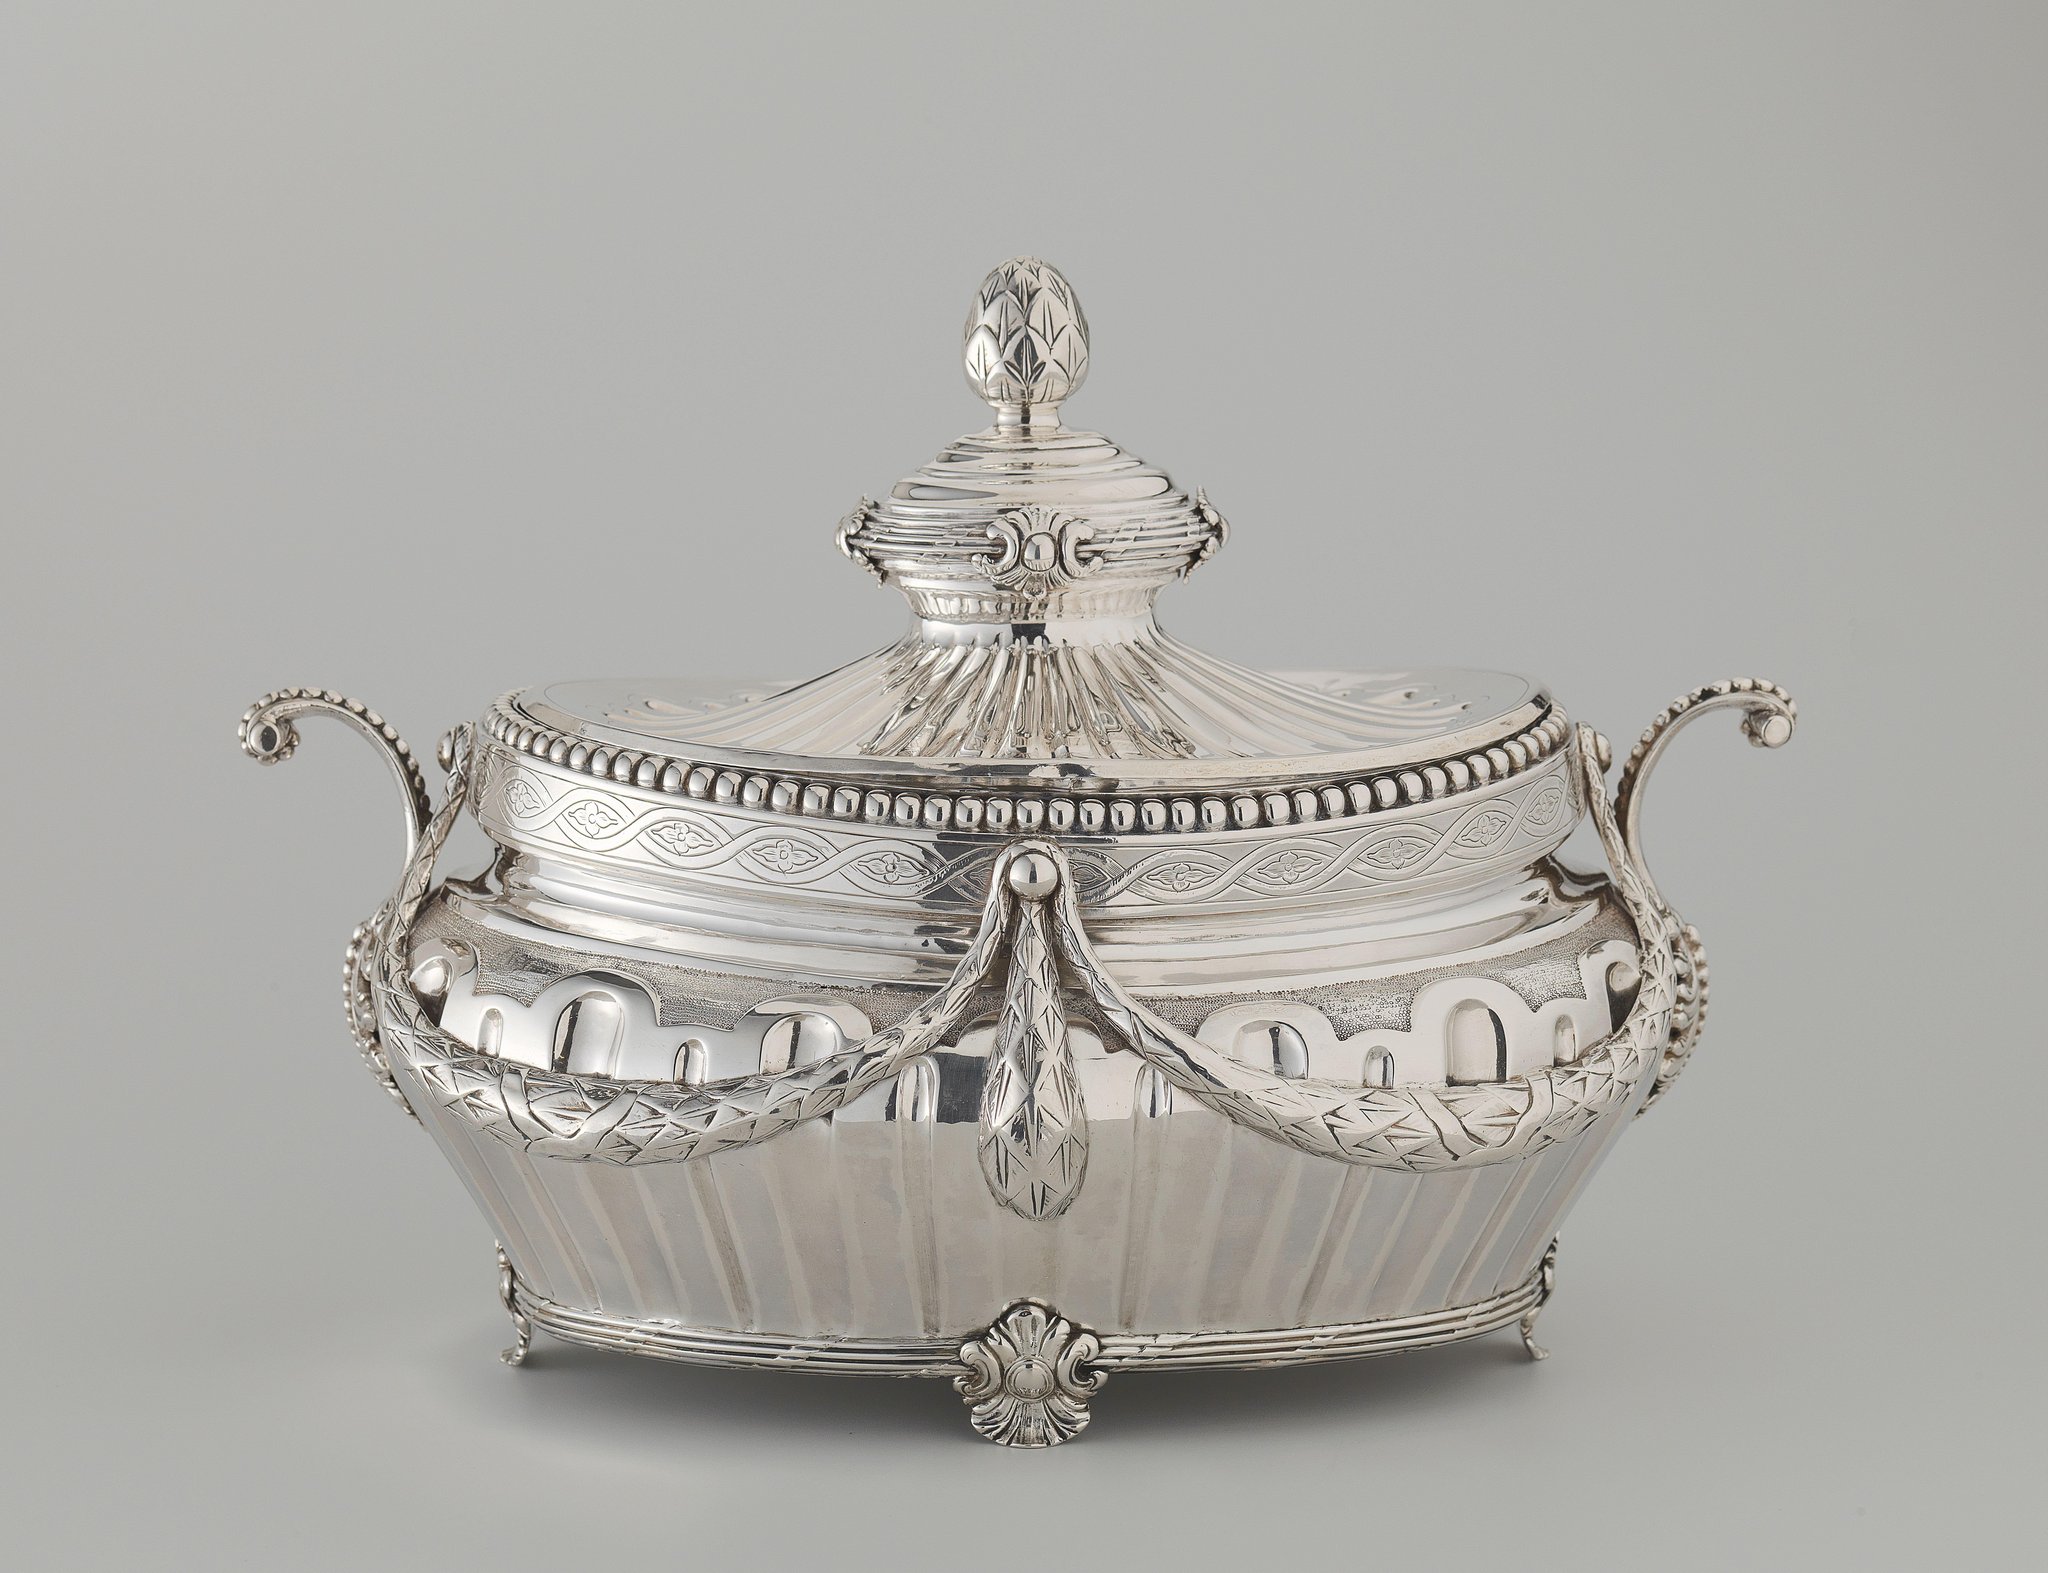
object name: tureen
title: Deksel van een grote (A) ovale terrine in Lodewijk XVI-stijl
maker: philippus priee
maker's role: silversmith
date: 1773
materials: silver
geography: middelburg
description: Binnenbak van een grote (A) ovale terrine, in Lodewijk XVI-stijl.